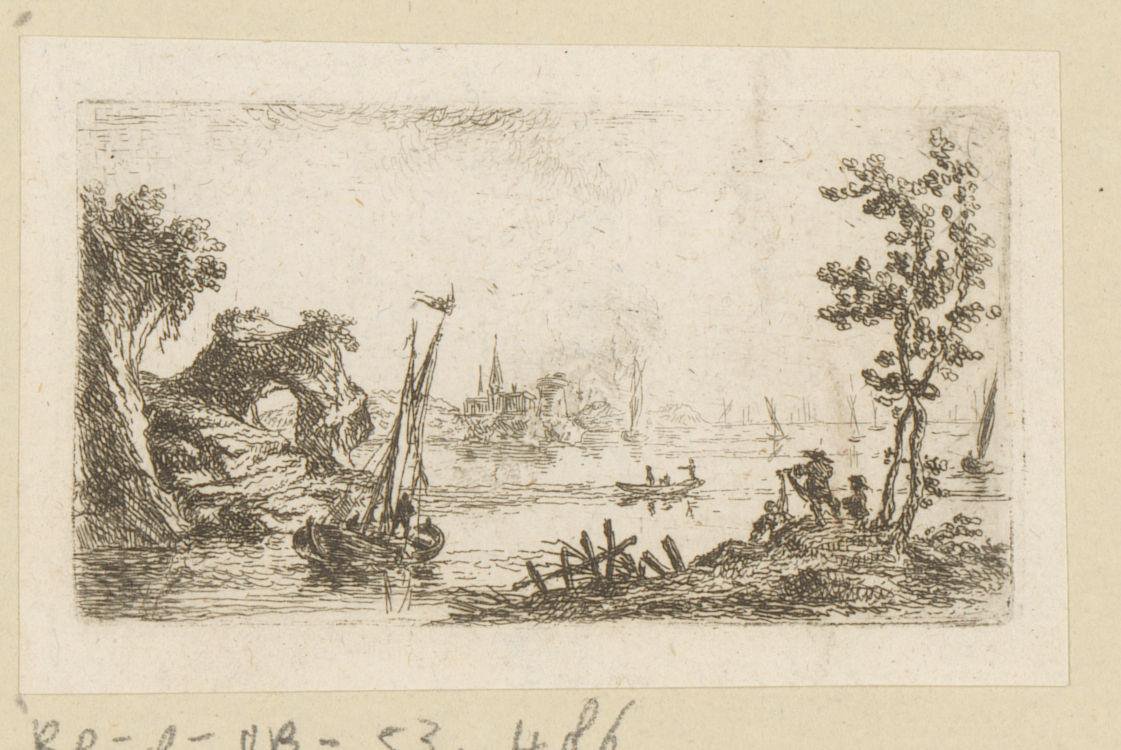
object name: print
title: Riviergezicht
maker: johann andreas benjamin nothnagel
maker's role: print maker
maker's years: 1729-1804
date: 1739-1804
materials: paper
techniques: etching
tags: landscapes with waters, waterscapes, seascapes (in the temperate zone)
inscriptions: collector's mark: Lugt 240